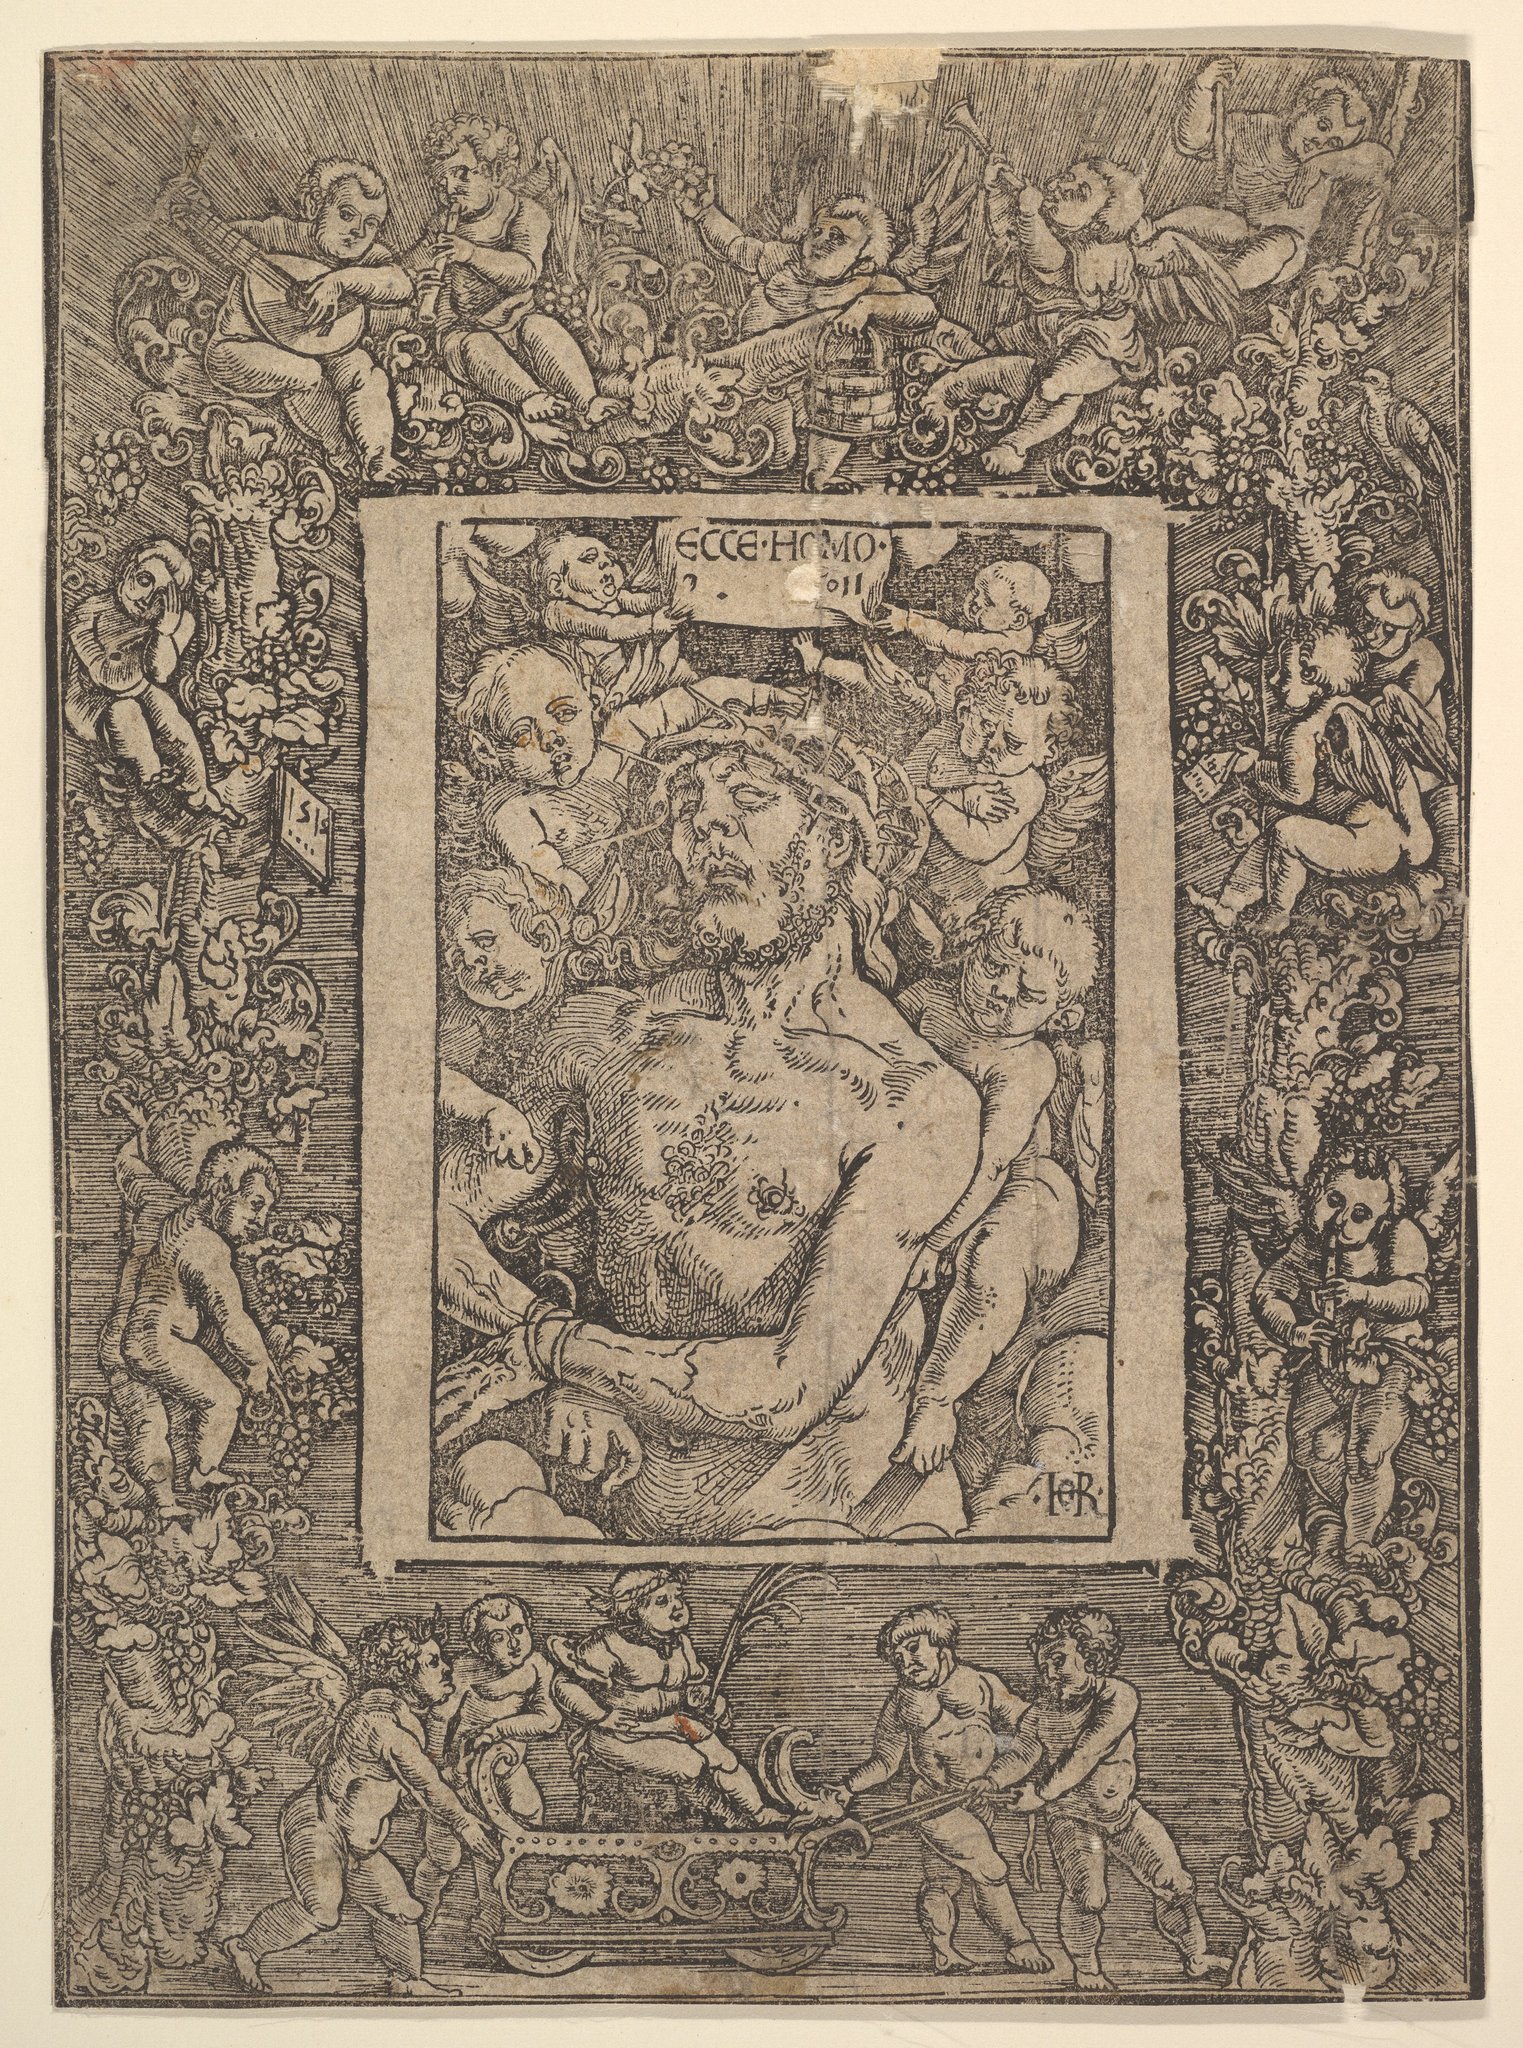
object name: print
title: Ecce Homo with Ornamental Border showing the Triumph of Bacchus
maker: hans baldung (called hans baldung grien)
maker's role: artist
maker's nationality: german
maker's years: 1484-1545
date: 1511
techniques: woodcut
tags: bacchus,christ